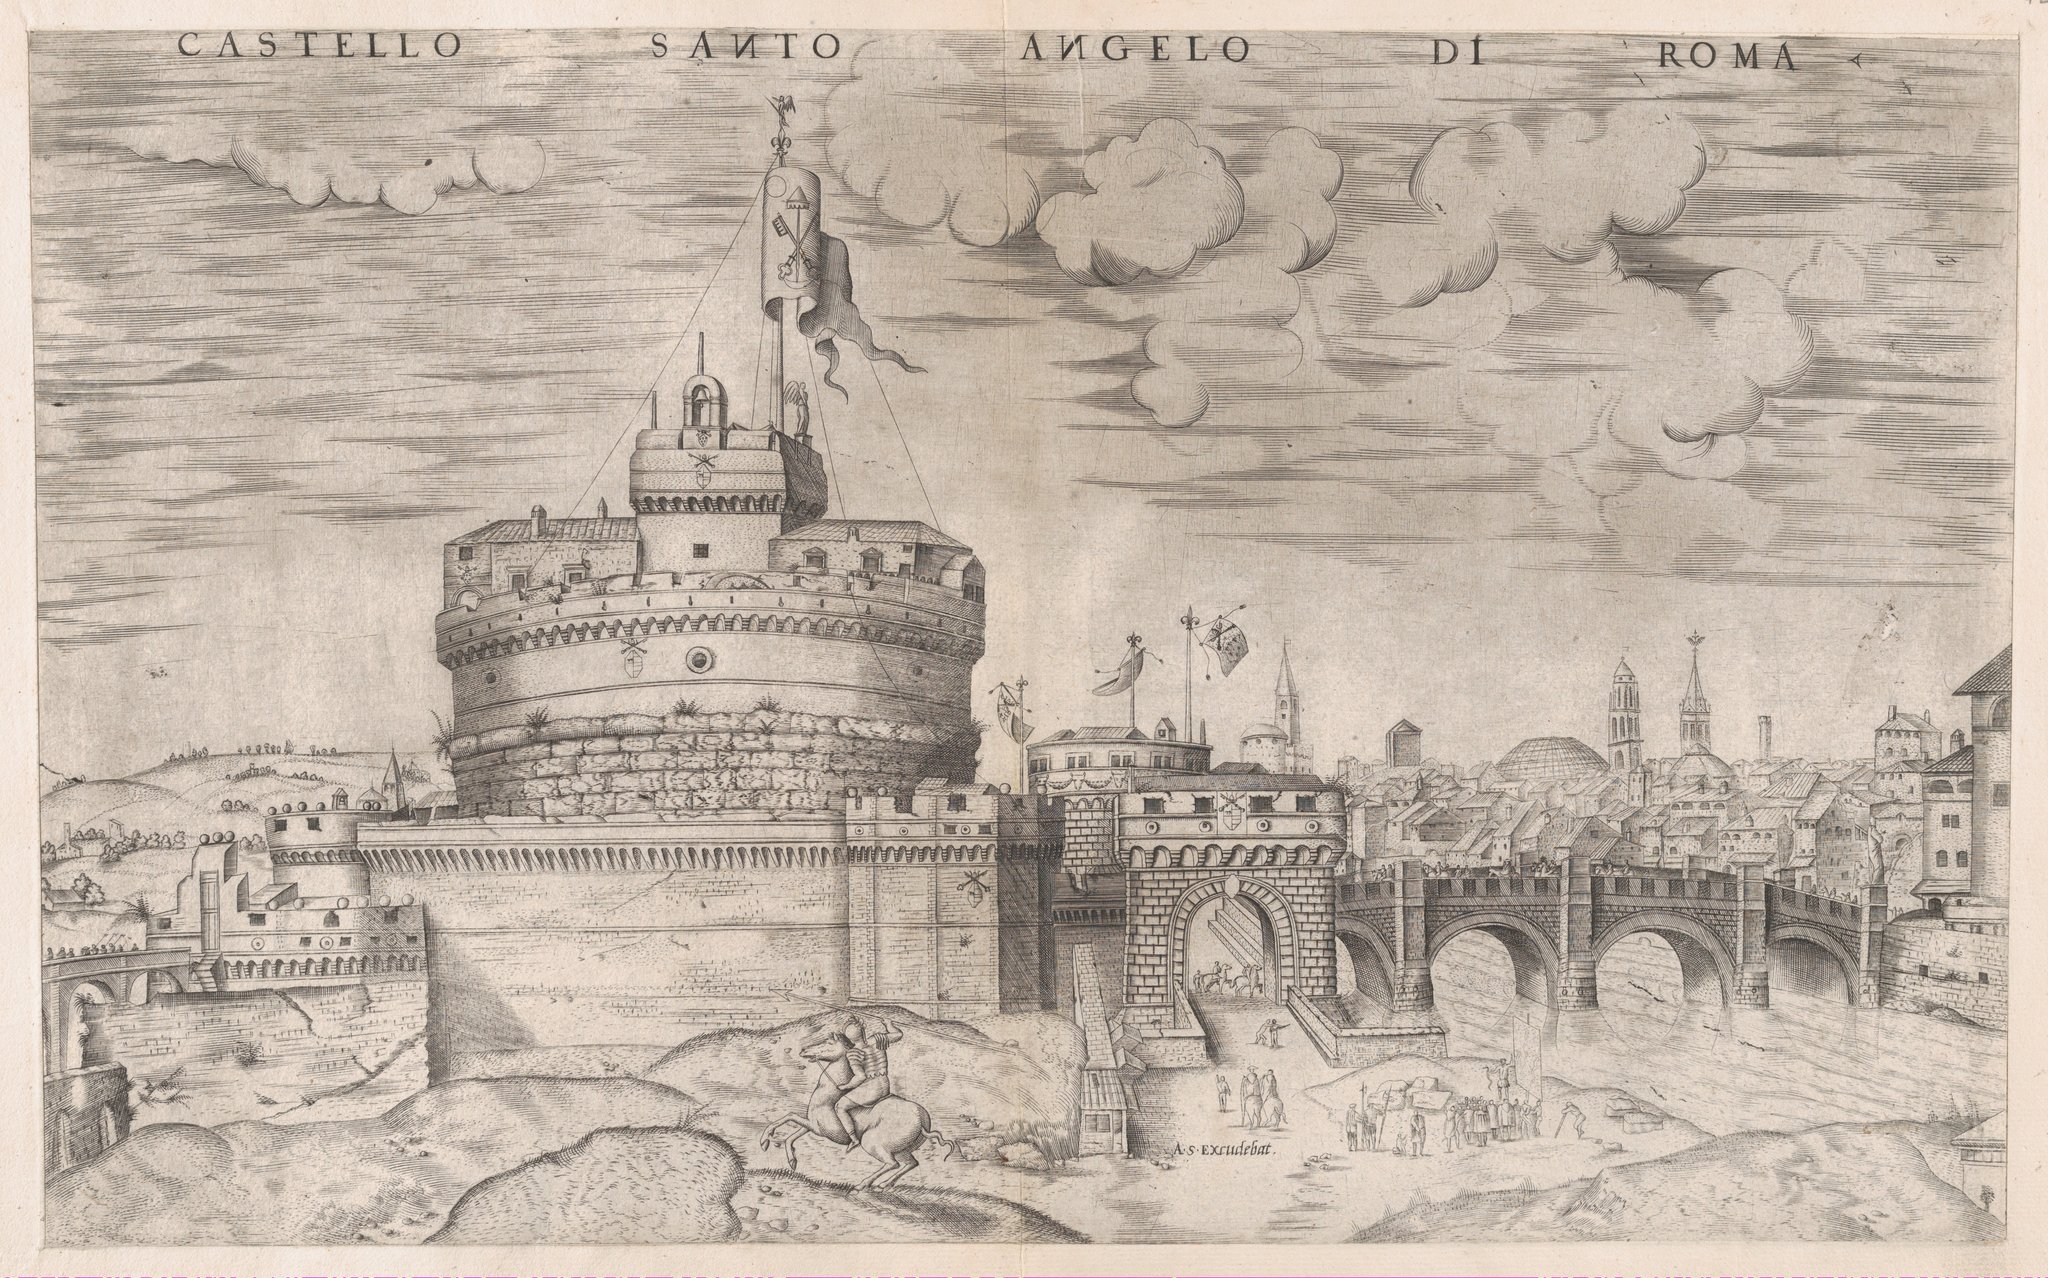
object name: print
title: Castello Sant' Angelo, from "Speculum Romanae Magnificentiae"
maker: Anonymous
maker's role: artist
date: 1501-1600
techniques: engraving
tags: castles,flags,rome